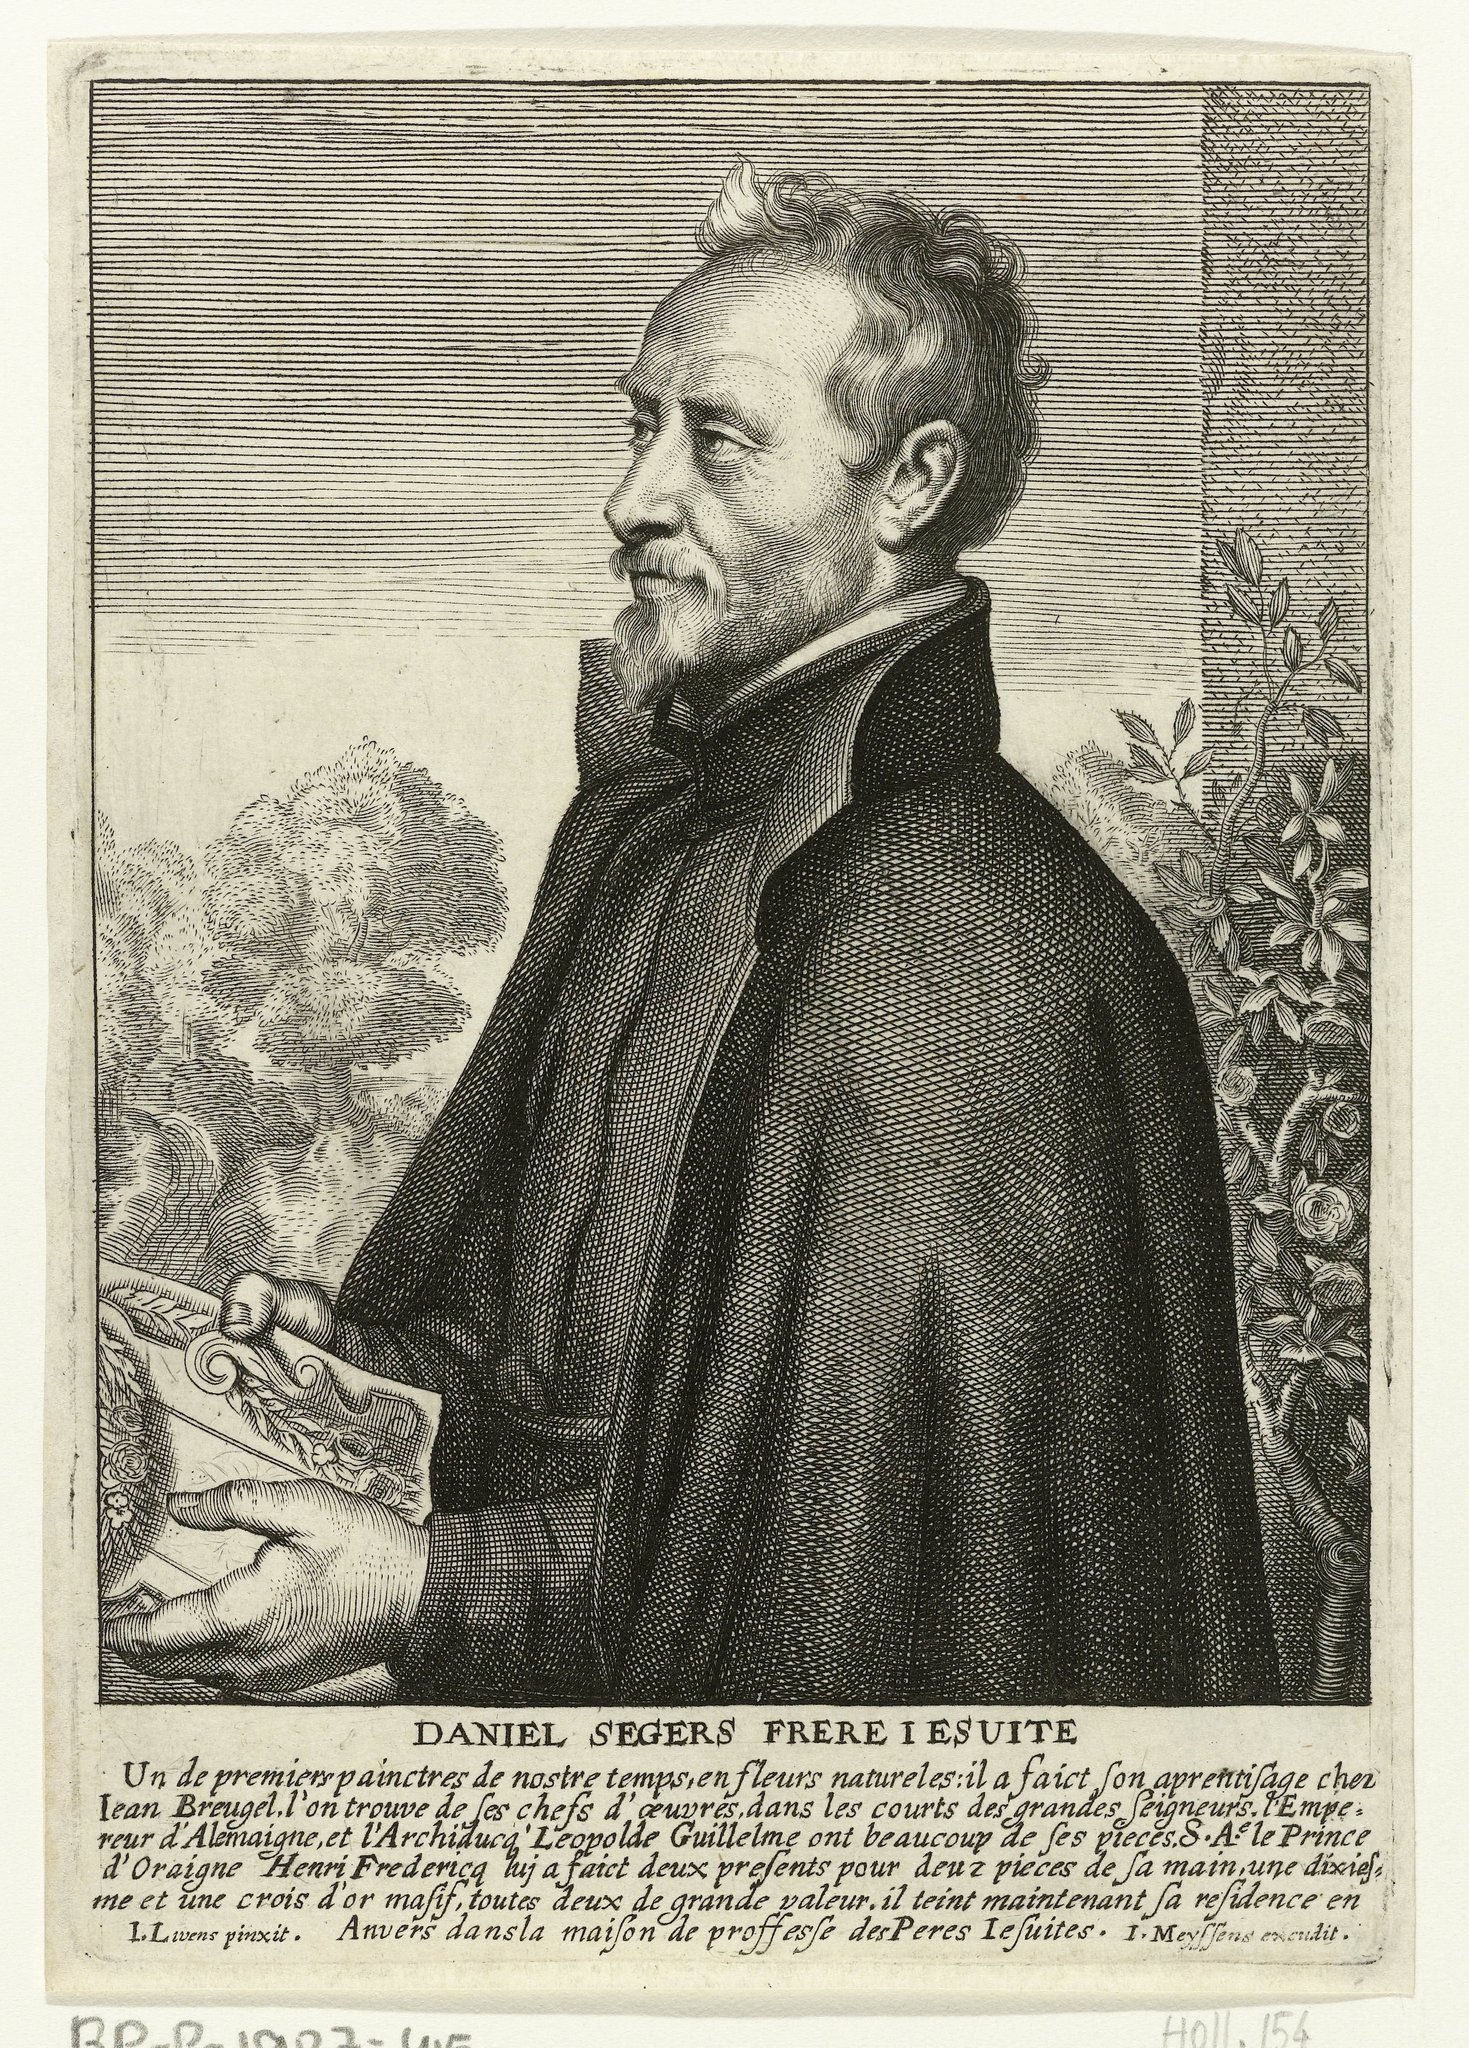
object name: print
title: Portret van Daniël Seghers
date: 1628-1670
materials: paper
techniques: engraving, etching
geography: antwerp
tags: painter, print, e.g.: engraving, etching, lithograph, shrubs: rose-bush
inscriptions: collector's mark: Lugt 2228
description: Portret van Daniël Seghers, ten halven lijve. In zijn handen houdt hij een prent. Achter hem een rozenstruik. Op de achtergrond een met bomen omzoomd pad. In de marge de naam van de geportretteerde en een zesregelig onderschrift in het Frans.